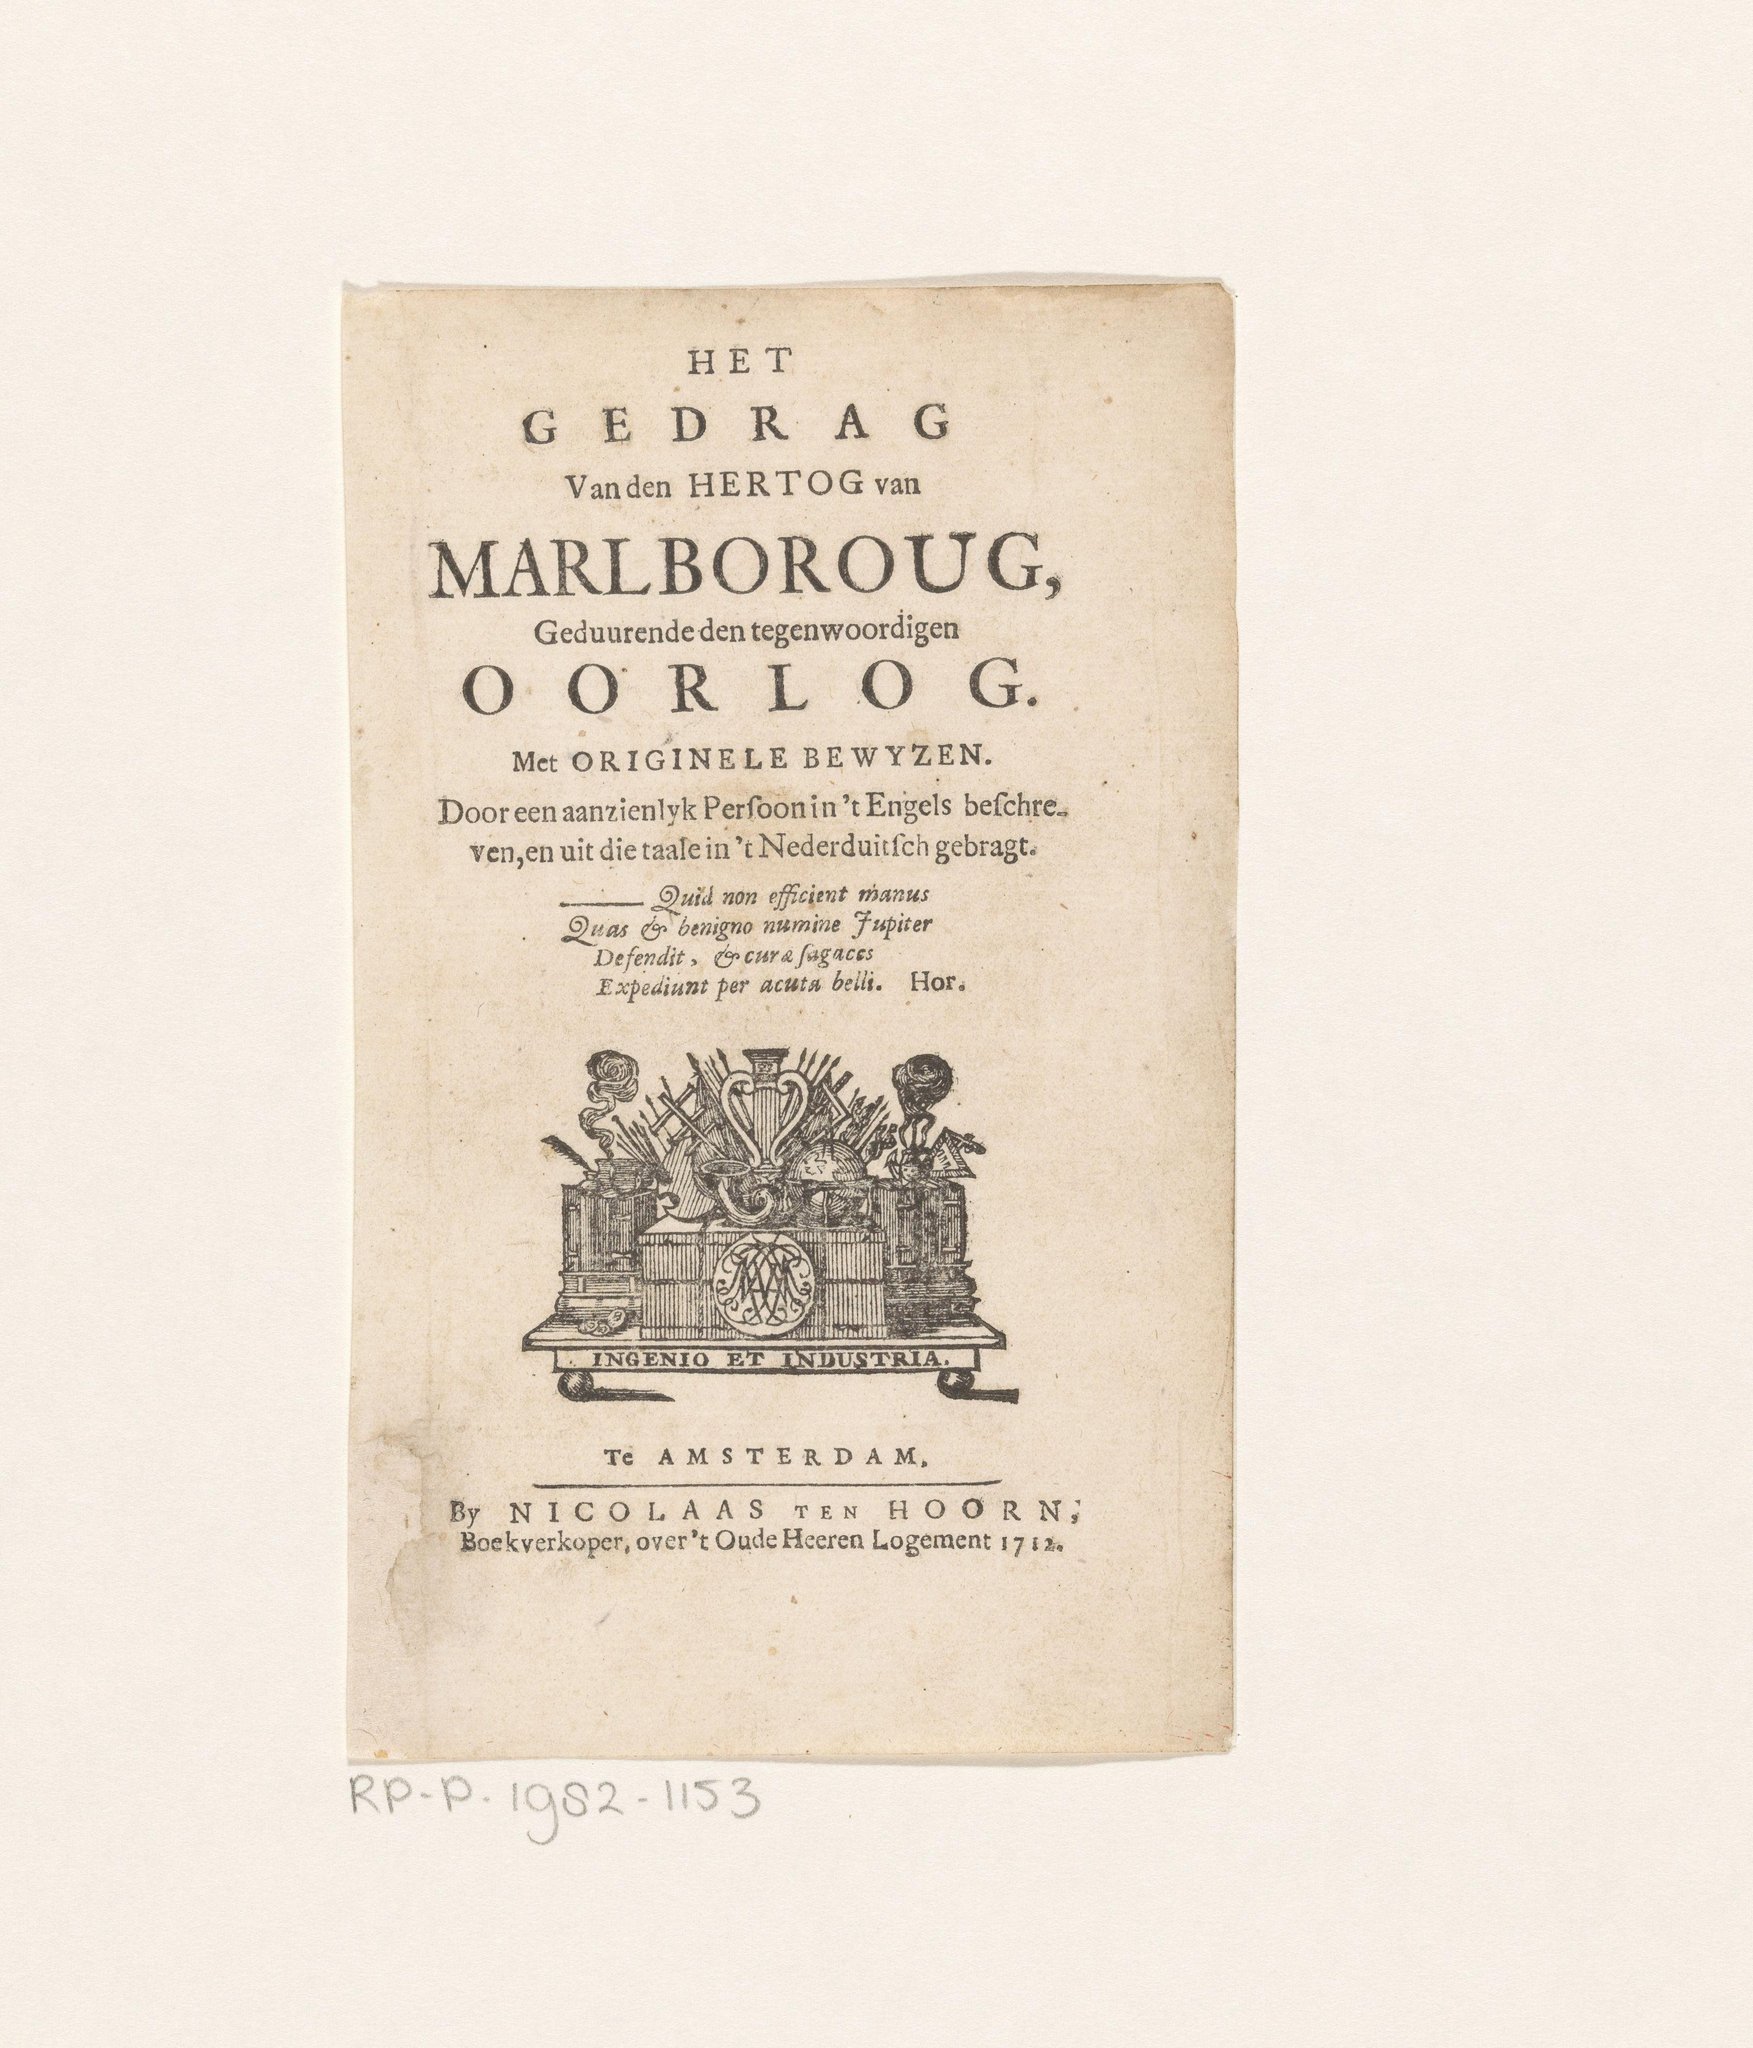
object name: print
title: Drukkersmerk Nicolaas ten Hoorn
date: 1712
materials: paper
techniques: letterpress printing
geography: amsterdam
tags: device (trade-mark of printer or publisher), armorial bearing, heraldry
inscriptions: collector's mark: Lugt 2228, collector's mark: Lugt 2760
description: Titelpagina met drukkersmerk van Nicolaas ten Hoorn met het motto: Ingenio et industria. In het midden een lier omgeven door boeken en artistieke en wetenschappelijke symbolen.